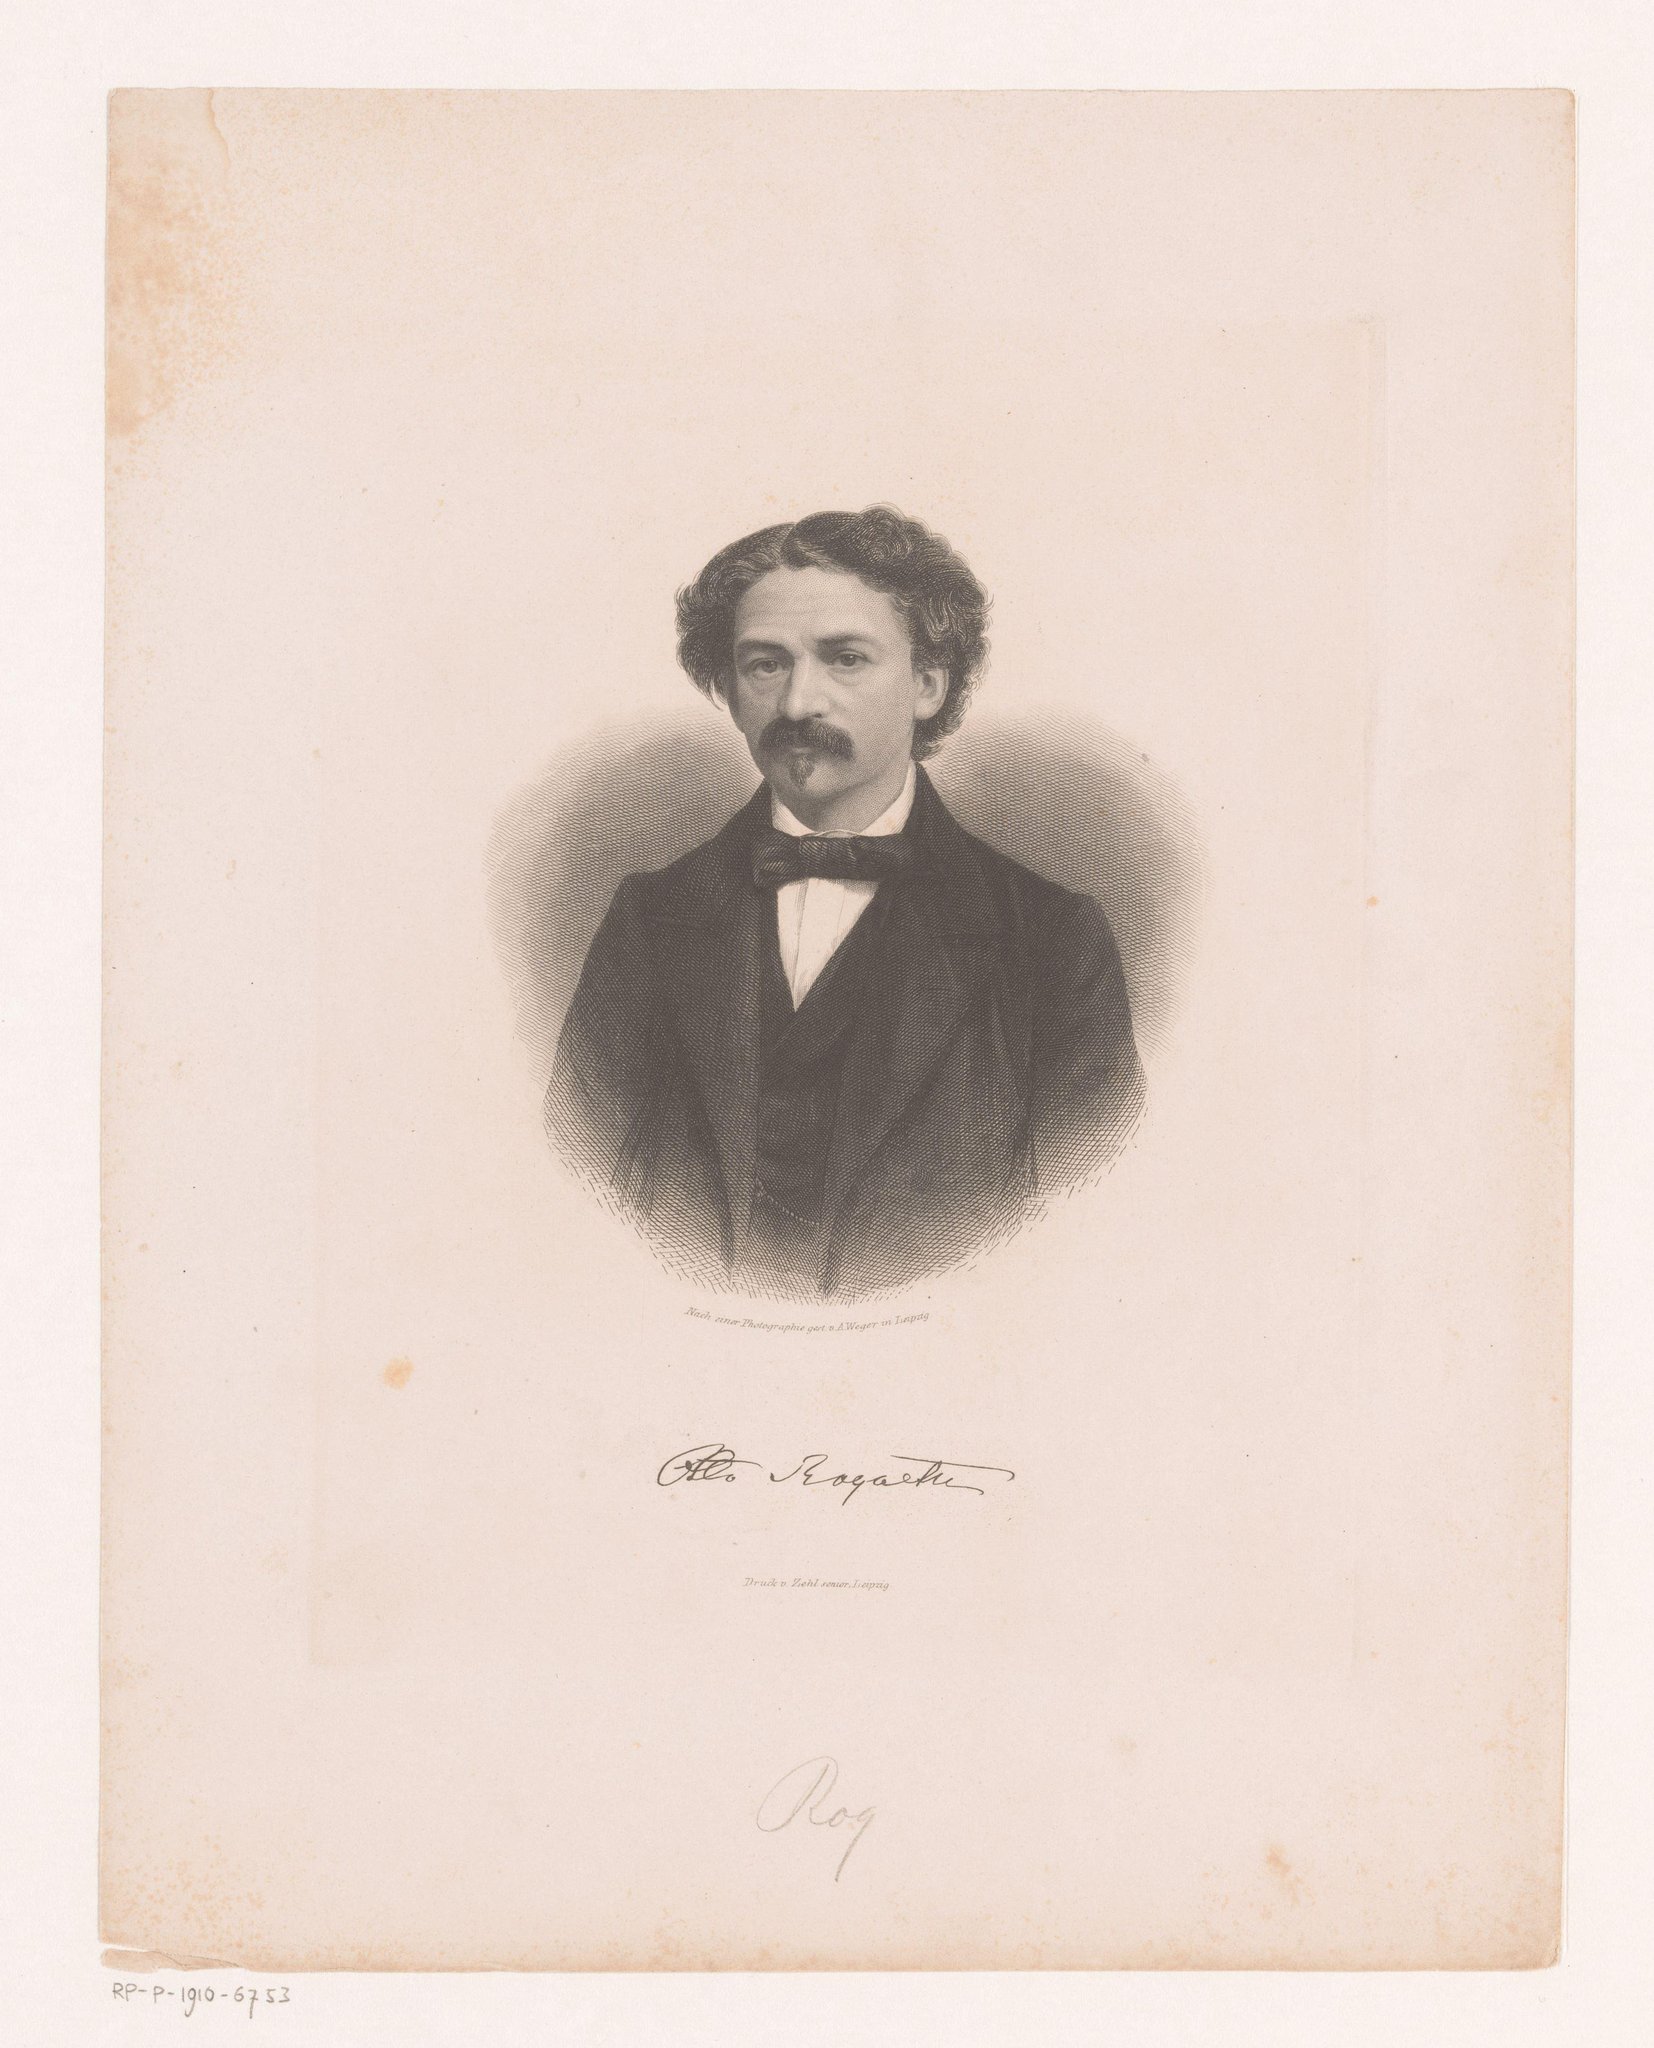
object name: print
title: Portret van Otto Roquette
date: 1860-1892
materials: paper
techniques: engraving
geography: leipzig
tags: poland, otto roquette, historical persons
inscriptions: collector's mark: Lugt 2228